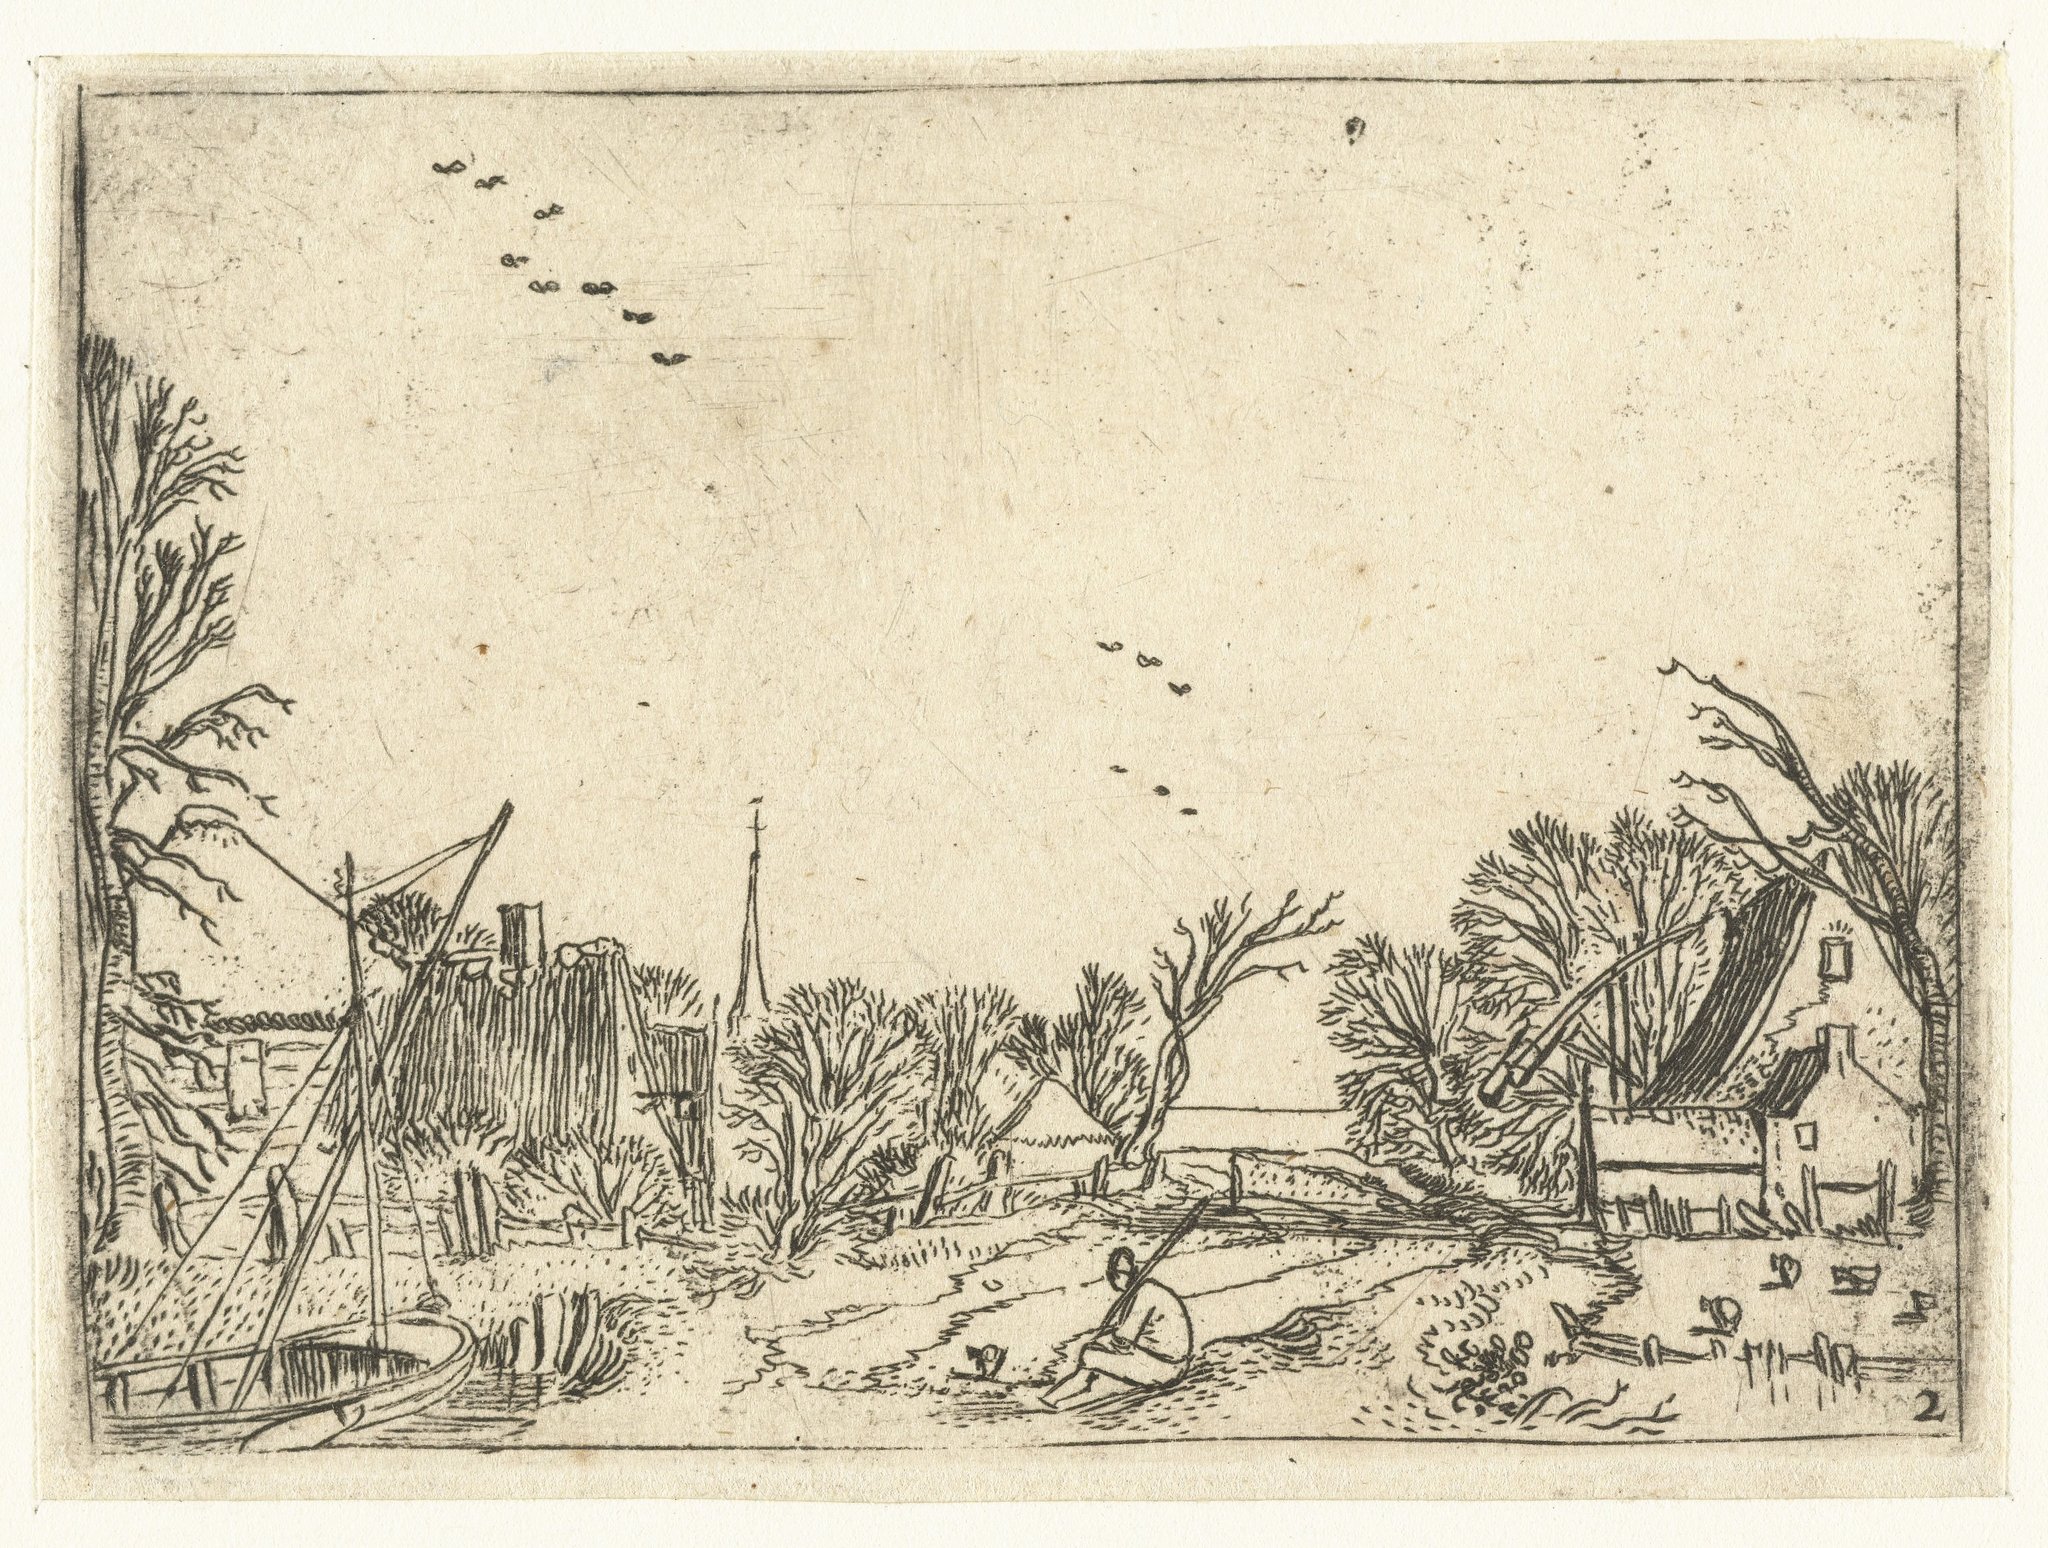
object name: print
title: Kleine landschappen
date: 1614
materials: paper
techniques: etching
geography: haarlem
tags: village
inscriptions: collector's mark: Lugt 240